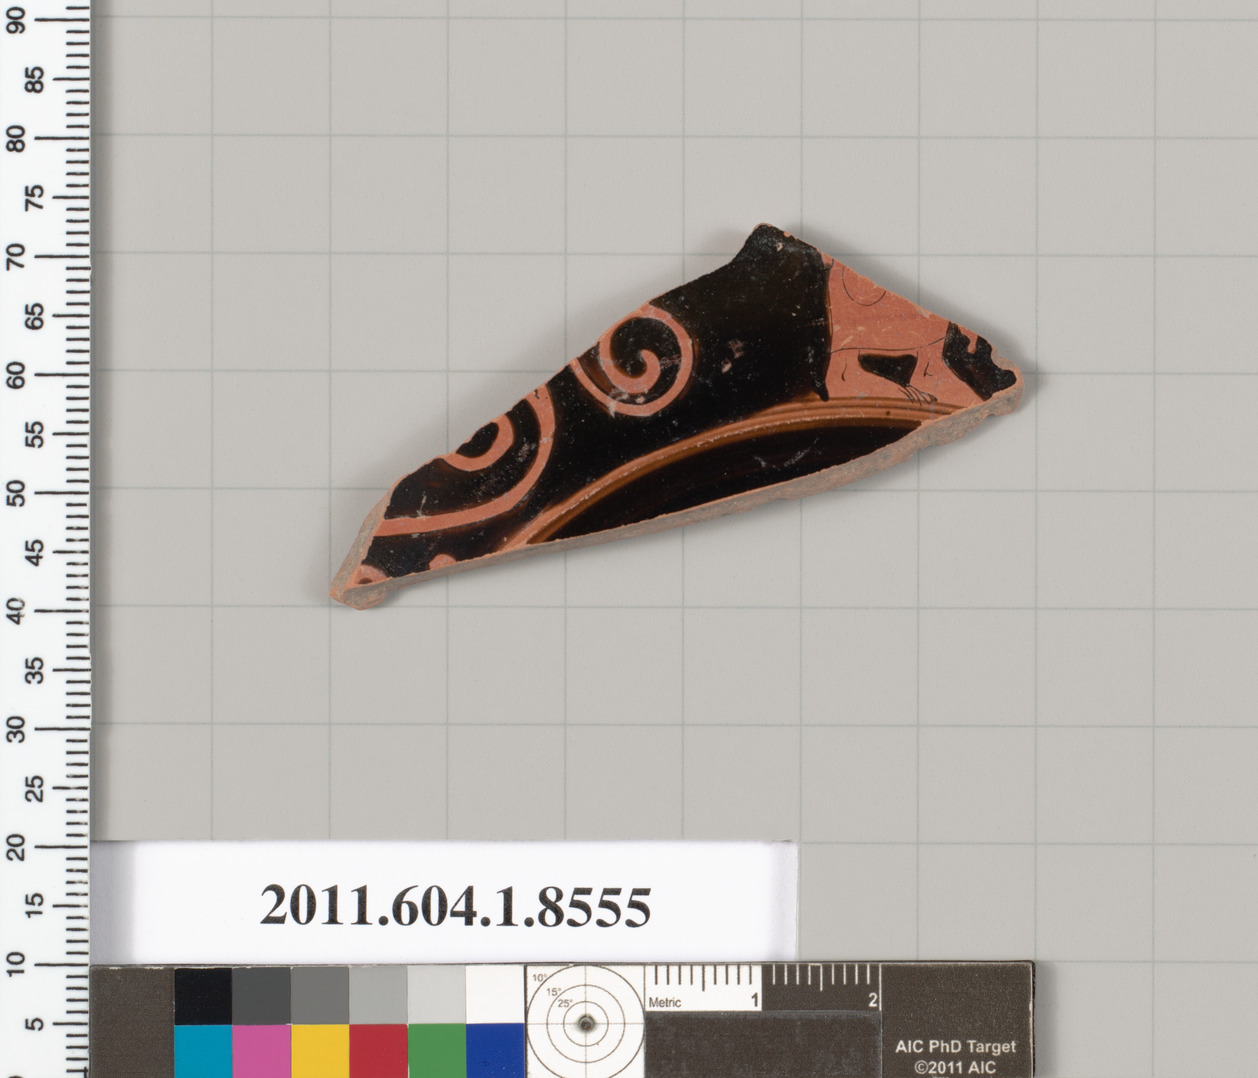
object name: kylix fragment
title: Terracotta fragment of a stemless kylix (drinking cup)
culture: greek, attic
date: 460-450 BCE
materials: terracotta